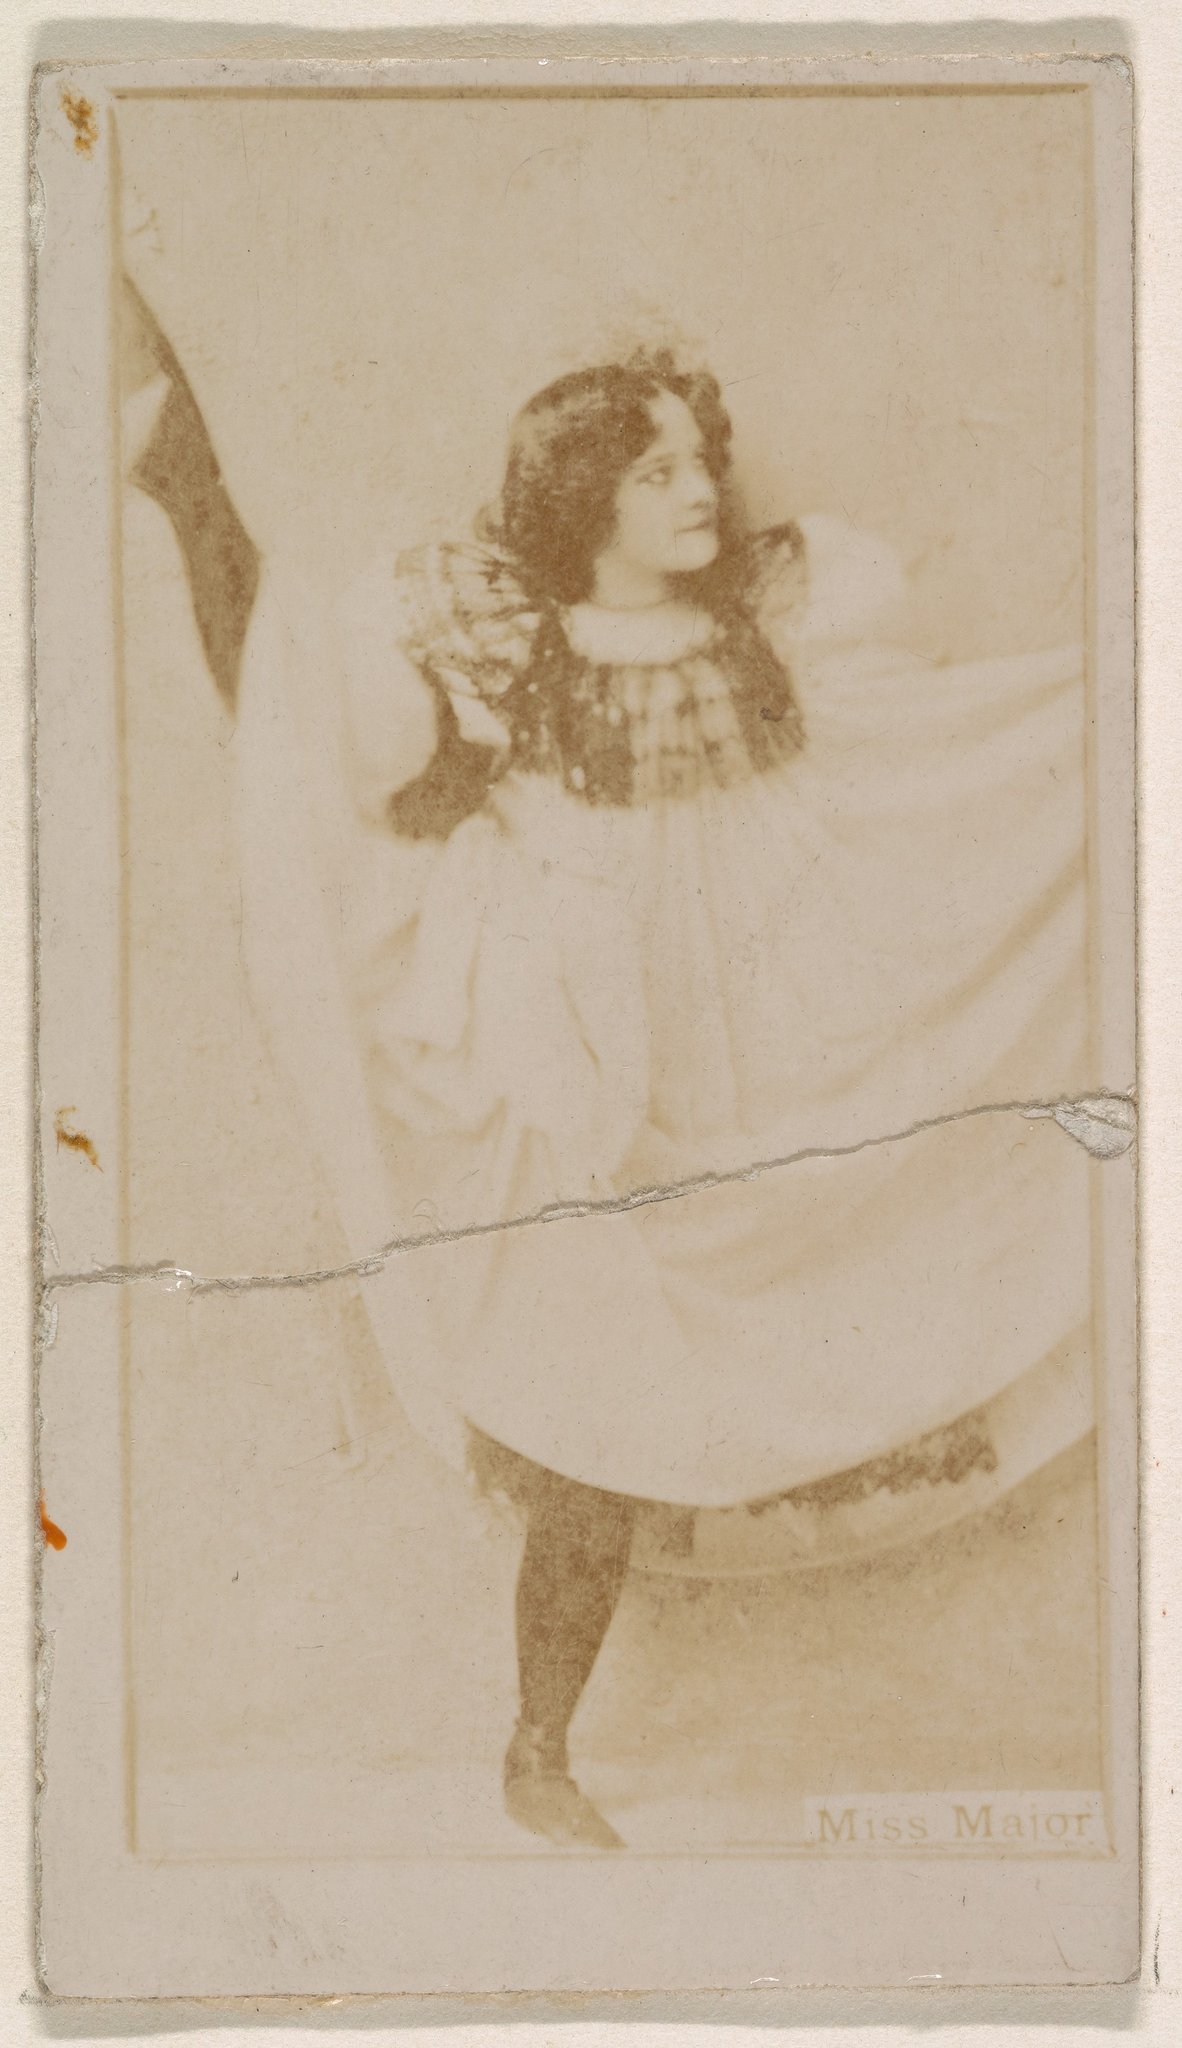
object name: photograph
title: Miss Major, from the Actresses series (N245) issued by Kinney Brothers to promote Sweet Caporal Cigarettes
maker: kinney brothers tobacco company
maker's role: publisher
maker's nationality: american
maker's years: 1869-2011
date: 1890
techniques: albumen silver print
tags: women,actresses